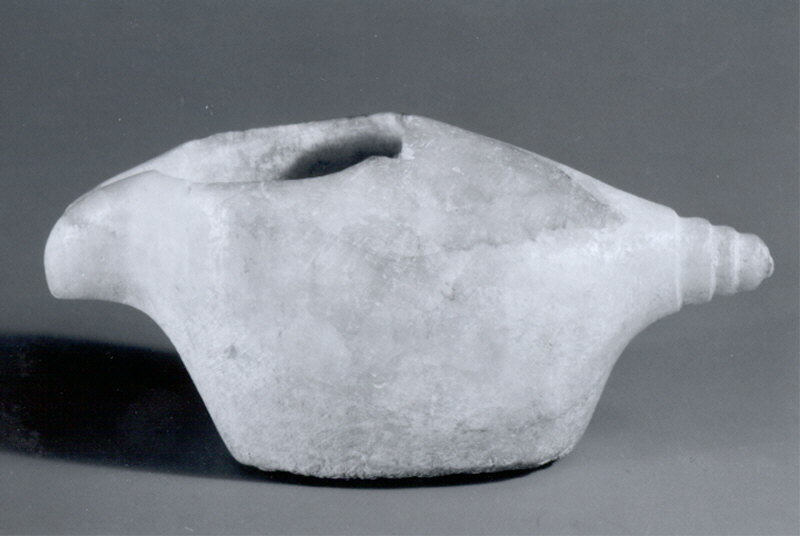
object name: bowl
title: Spouted bowl in the shape of a conch shell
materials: alabaster, gypsum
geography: iran or mesopotamia